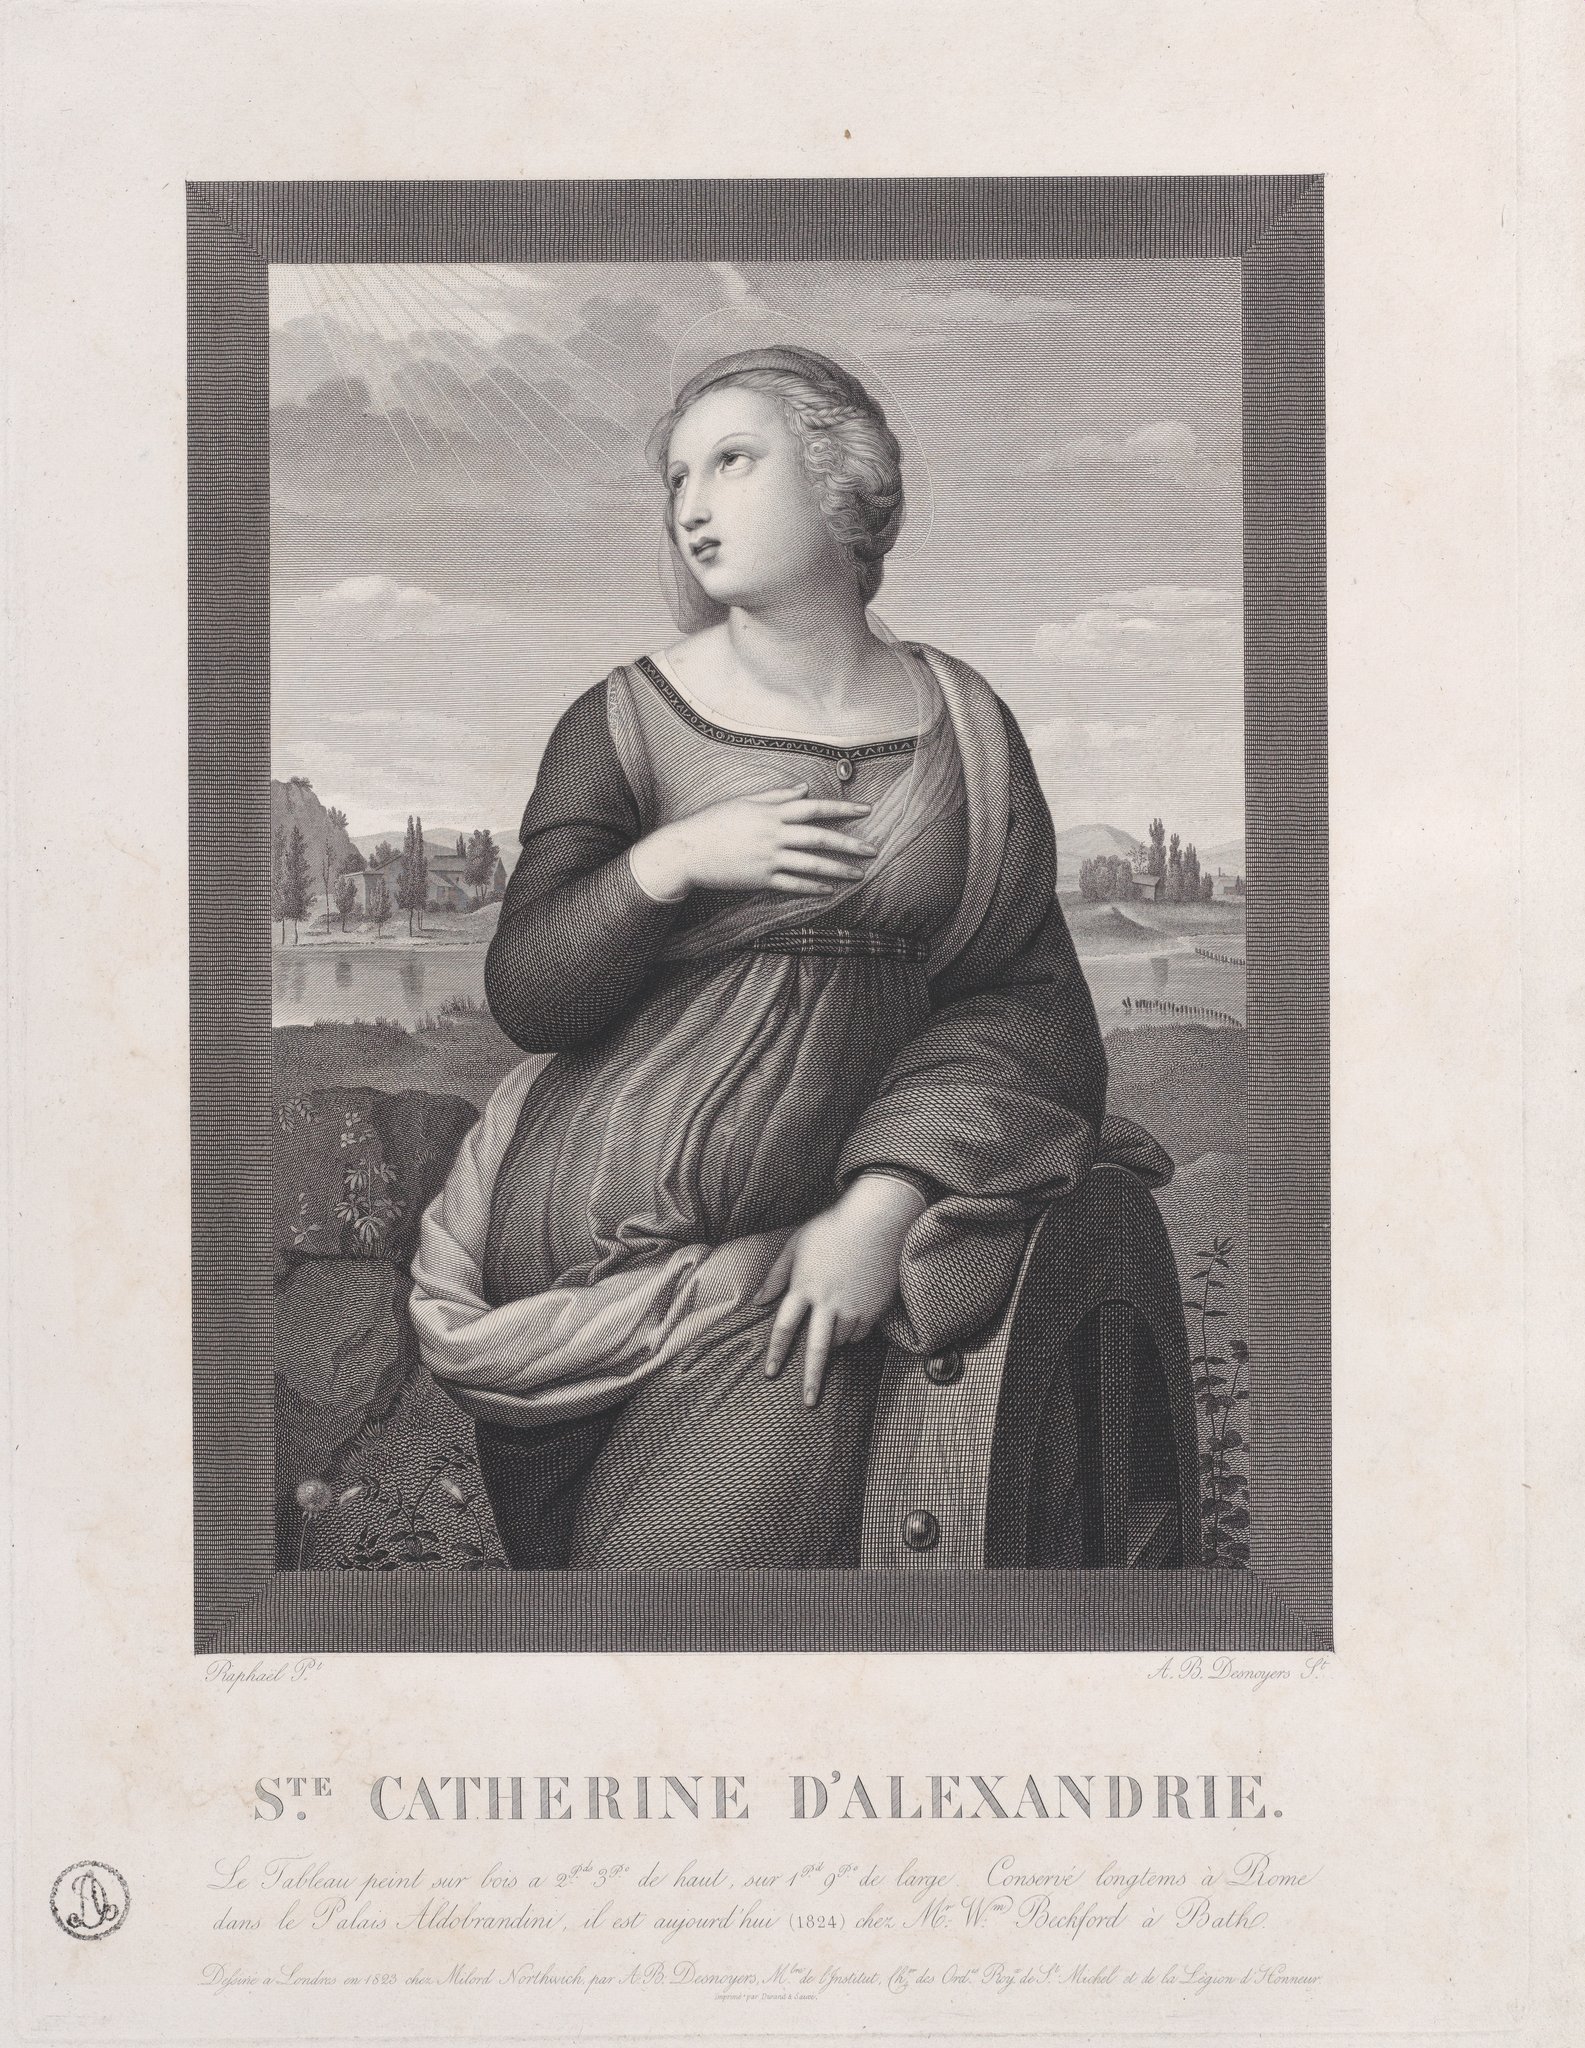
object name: print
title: Saint Catherine of Alexandria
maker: auguste gaspard louis boucher desnoyers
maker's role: artist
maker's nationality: french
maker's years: 1779-1857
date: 1824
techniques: engraving